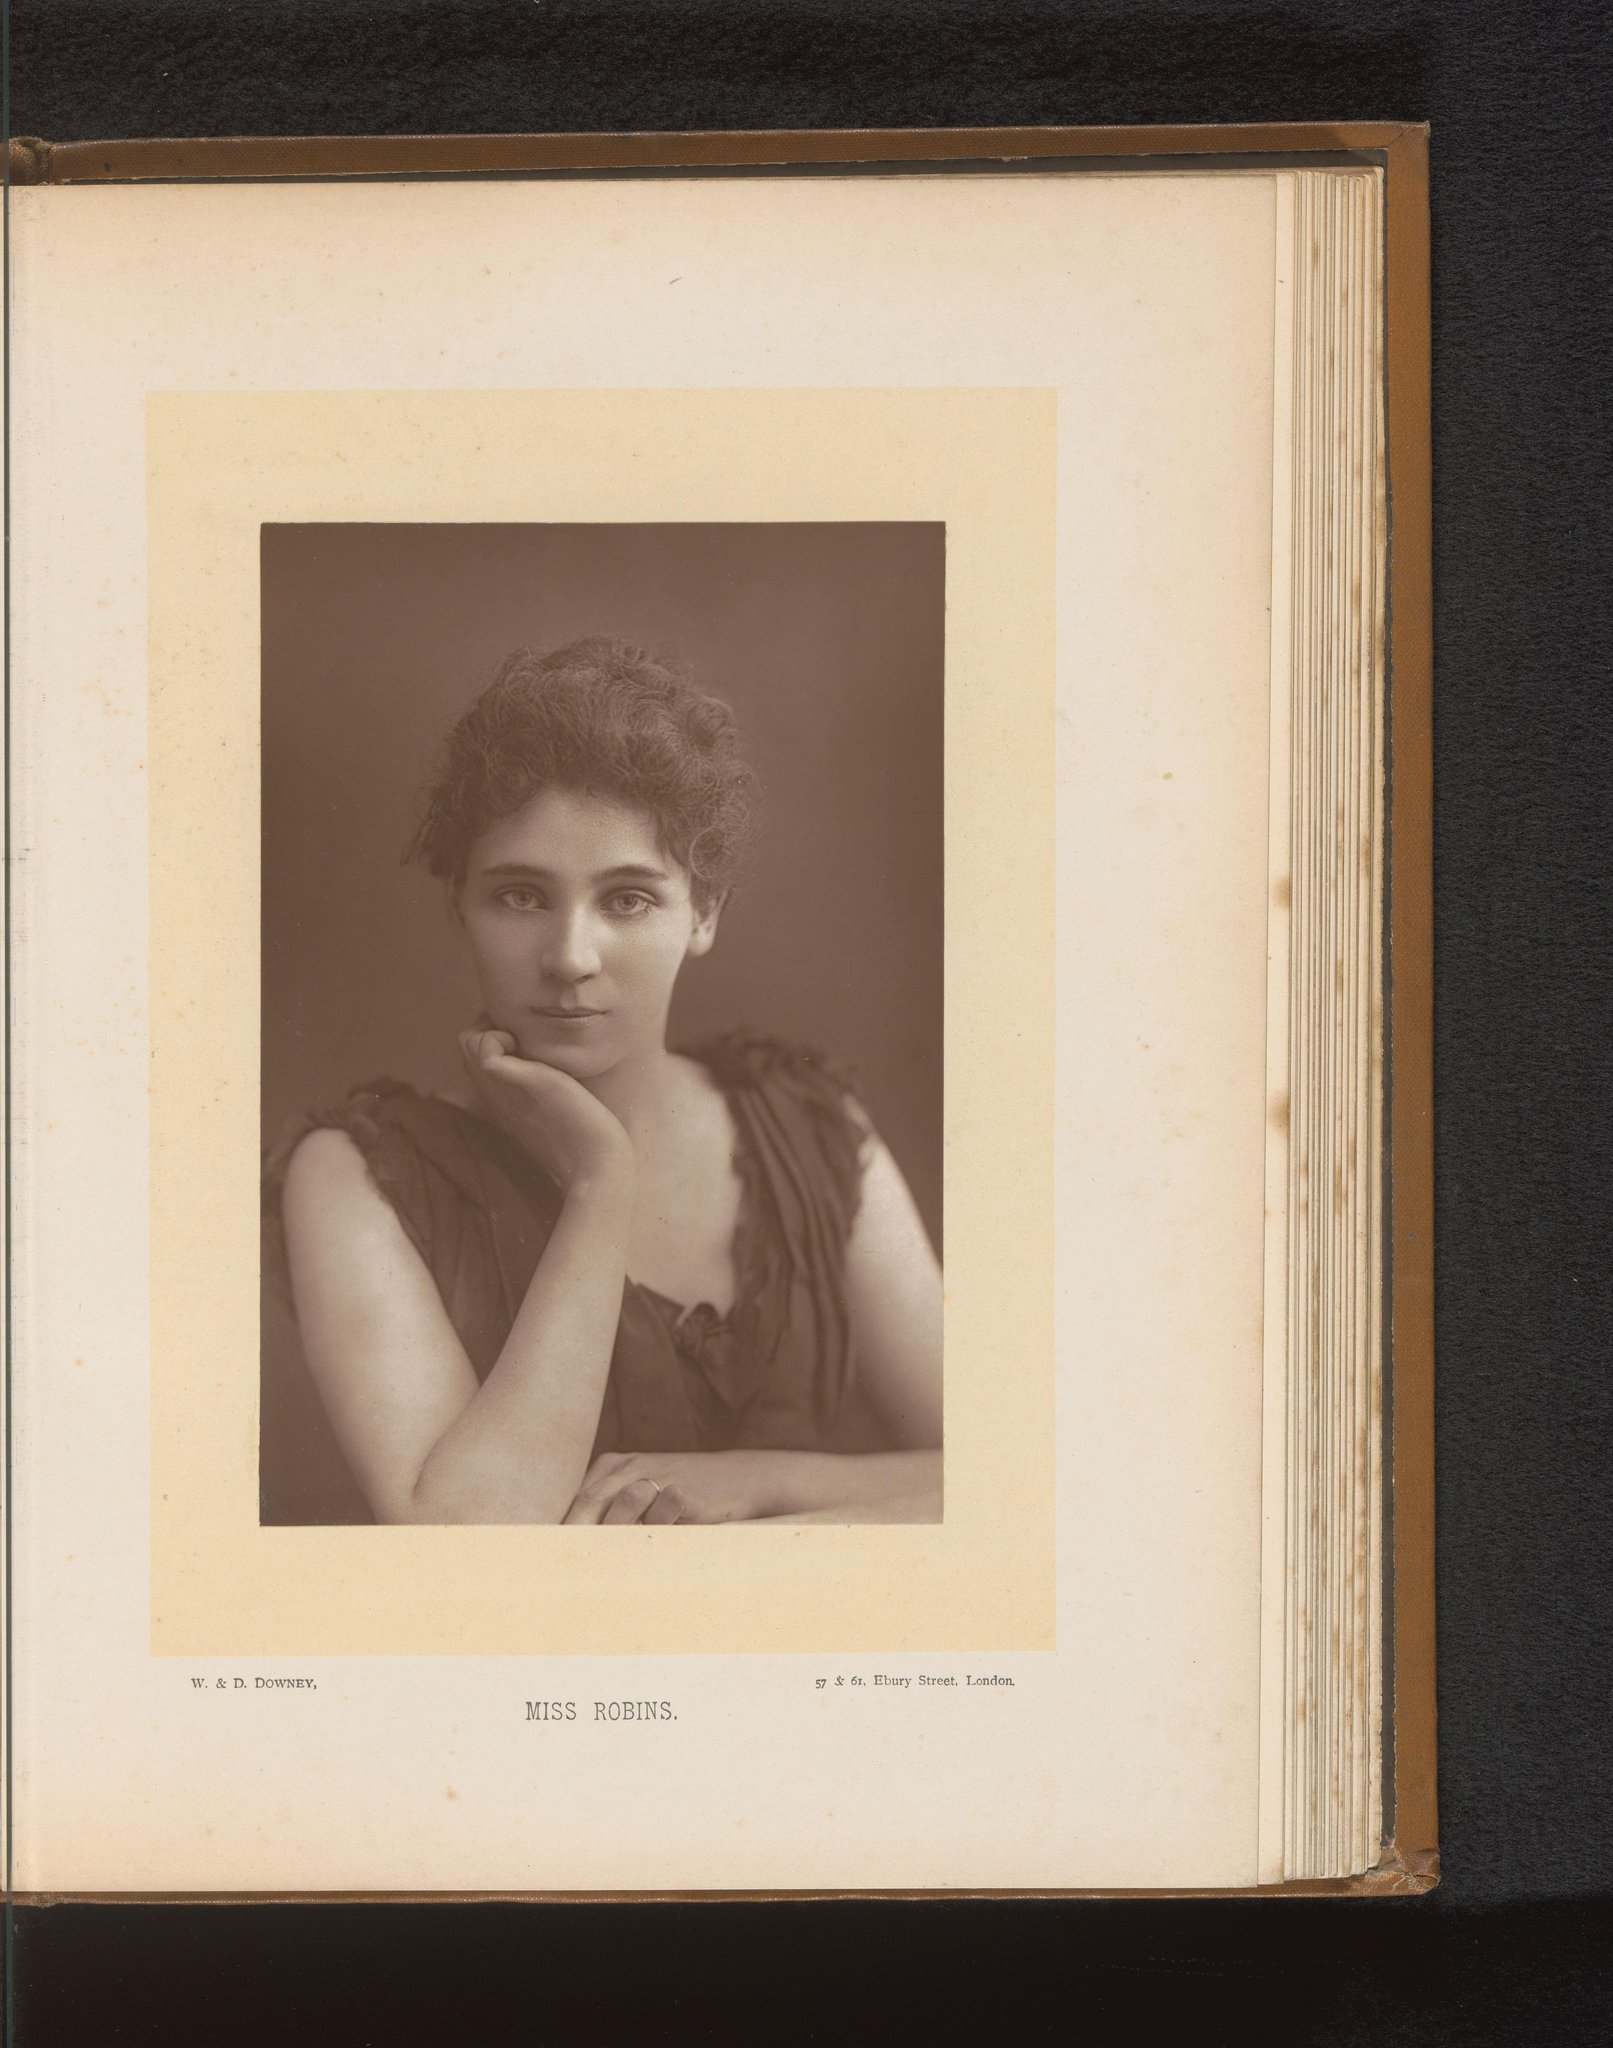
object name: page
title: Miss Robins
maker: Anonymous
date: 1883-1893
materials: paper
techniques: woodburytype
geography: london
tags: portrait of actor, actress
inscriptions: inscription: ‘57 & 61, Elbury Street, London.’